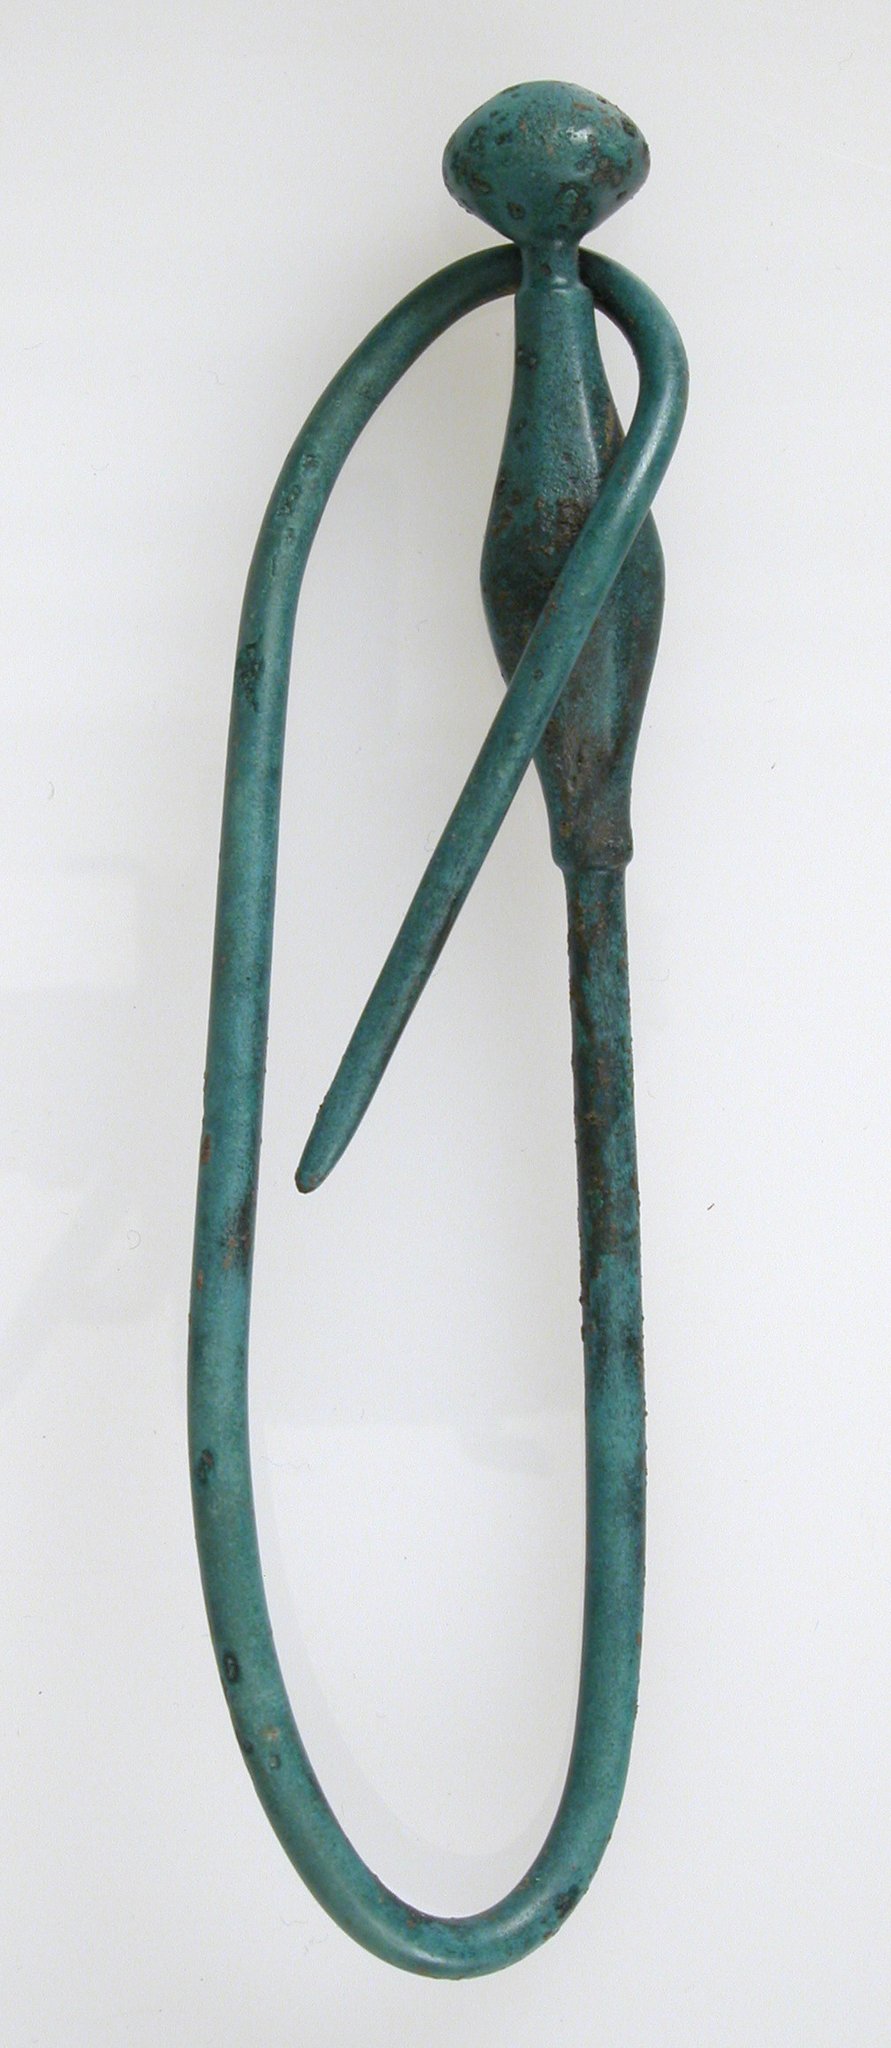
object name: pin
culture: bronze age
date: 1200-800 BCE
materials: copper alloy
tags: pins